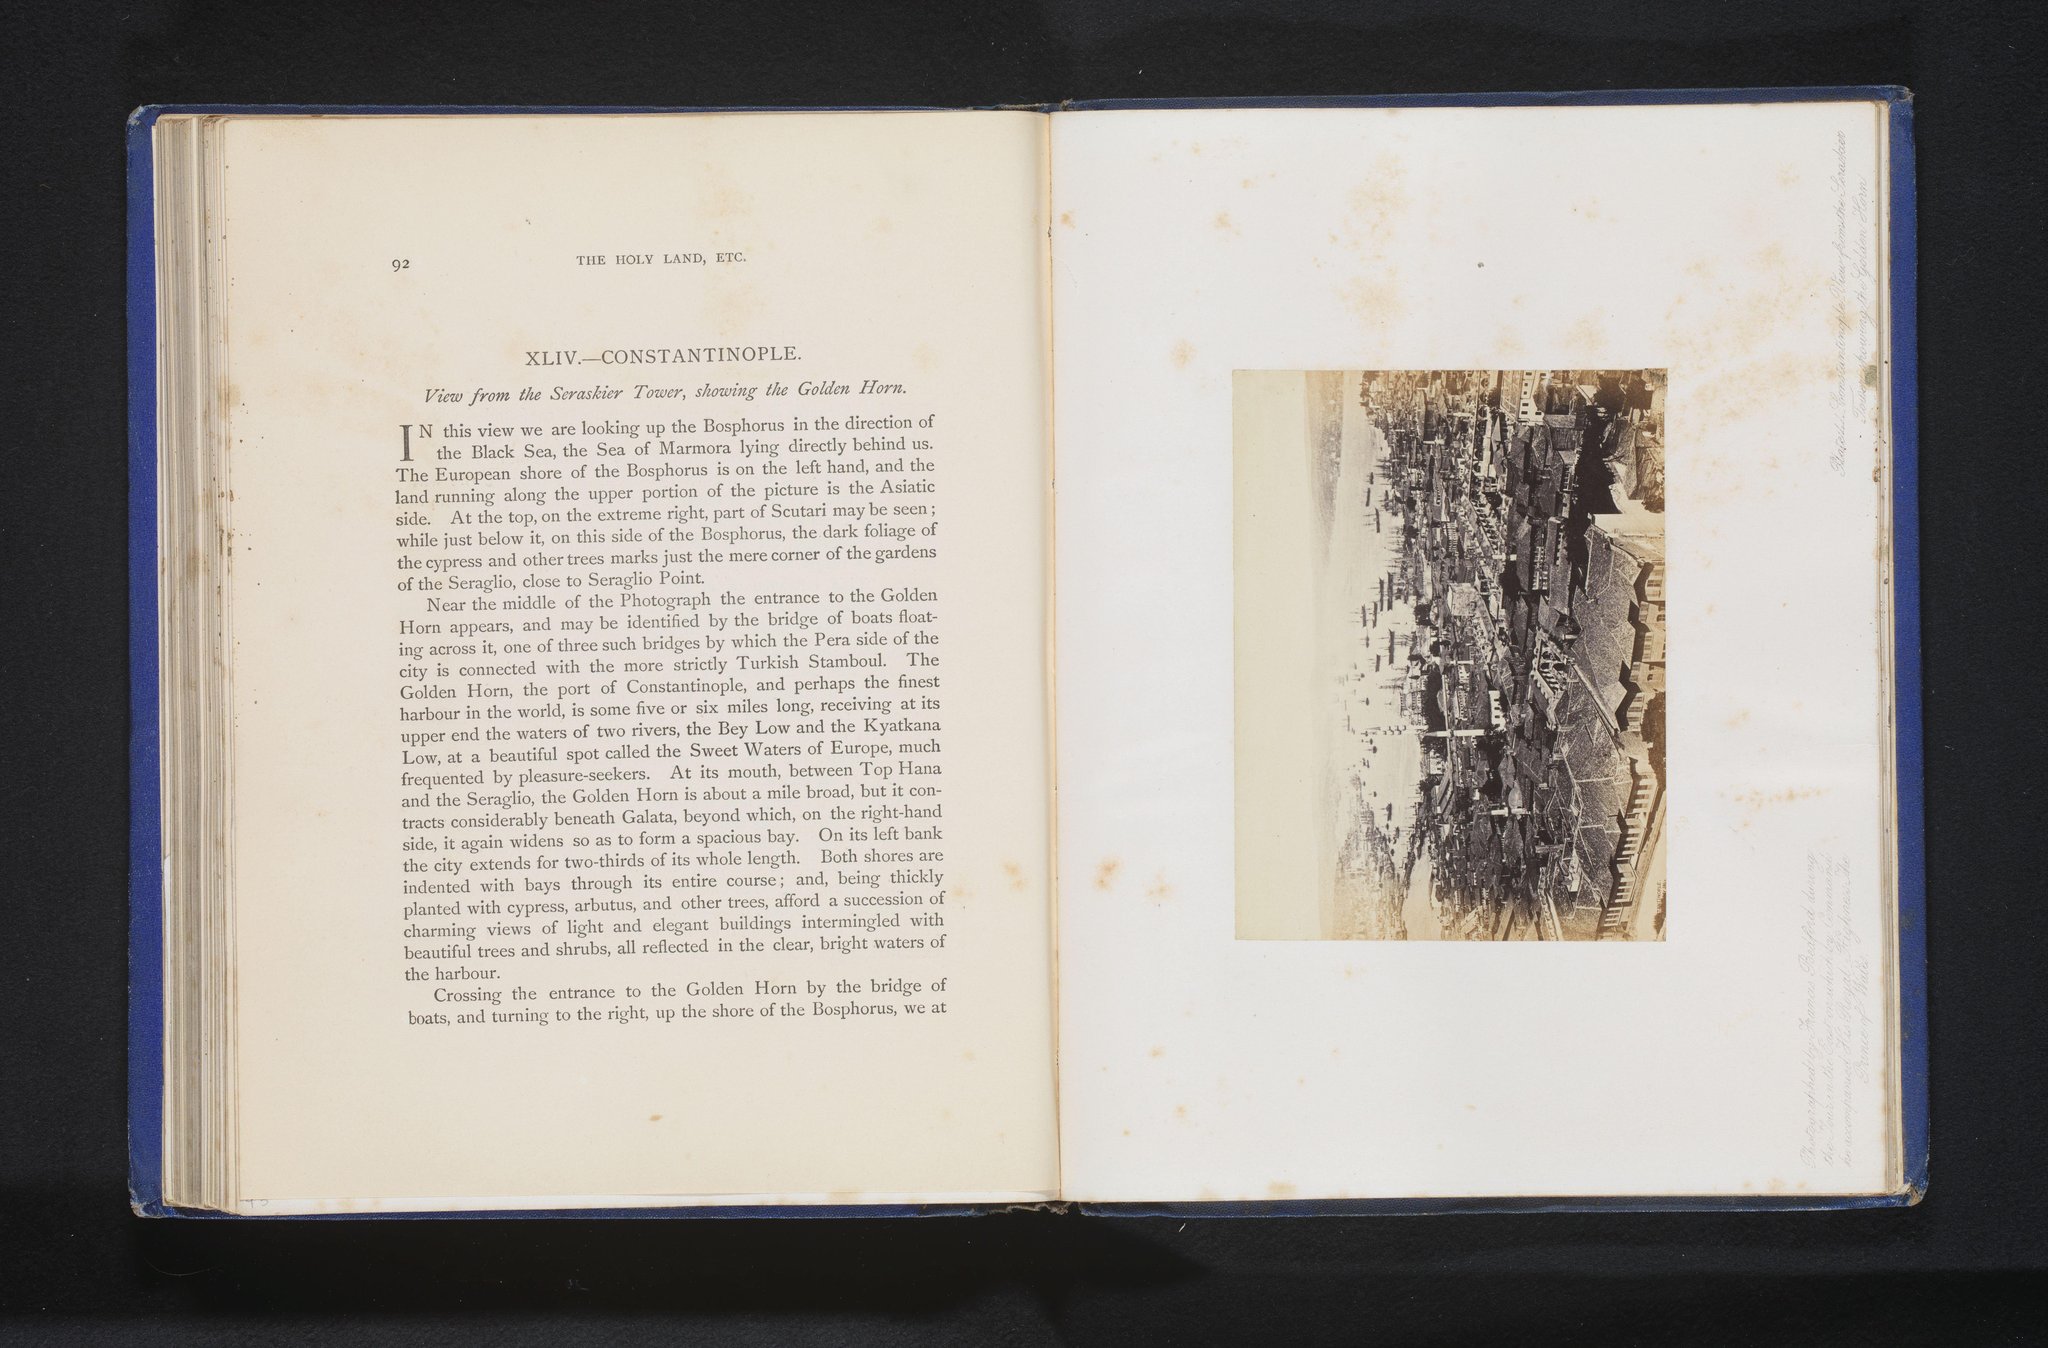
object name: photograph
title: Constantinople-View from the Seraskier Tower, showing the Golden Horn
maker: francis bedford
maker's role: print maker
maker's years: 1815-1894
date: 1861-1866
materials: photographic support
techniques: albumen print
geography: beyazıt tower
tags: gulf, bay, city-view in general; 'veduta'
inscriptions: number: ‘Plate 44.’, inscription: ‘Photographed by Francis Bedford during the Tour in the East on which by Command he accompanied His Royal Highness The Prince of Wales’